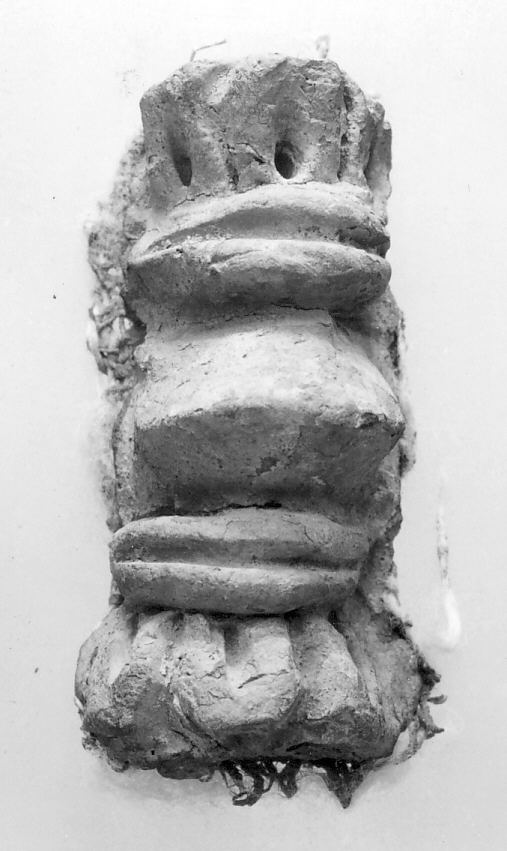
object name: ornament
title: Fragment of an Ornament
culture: central asian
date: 1101-1133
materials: clay